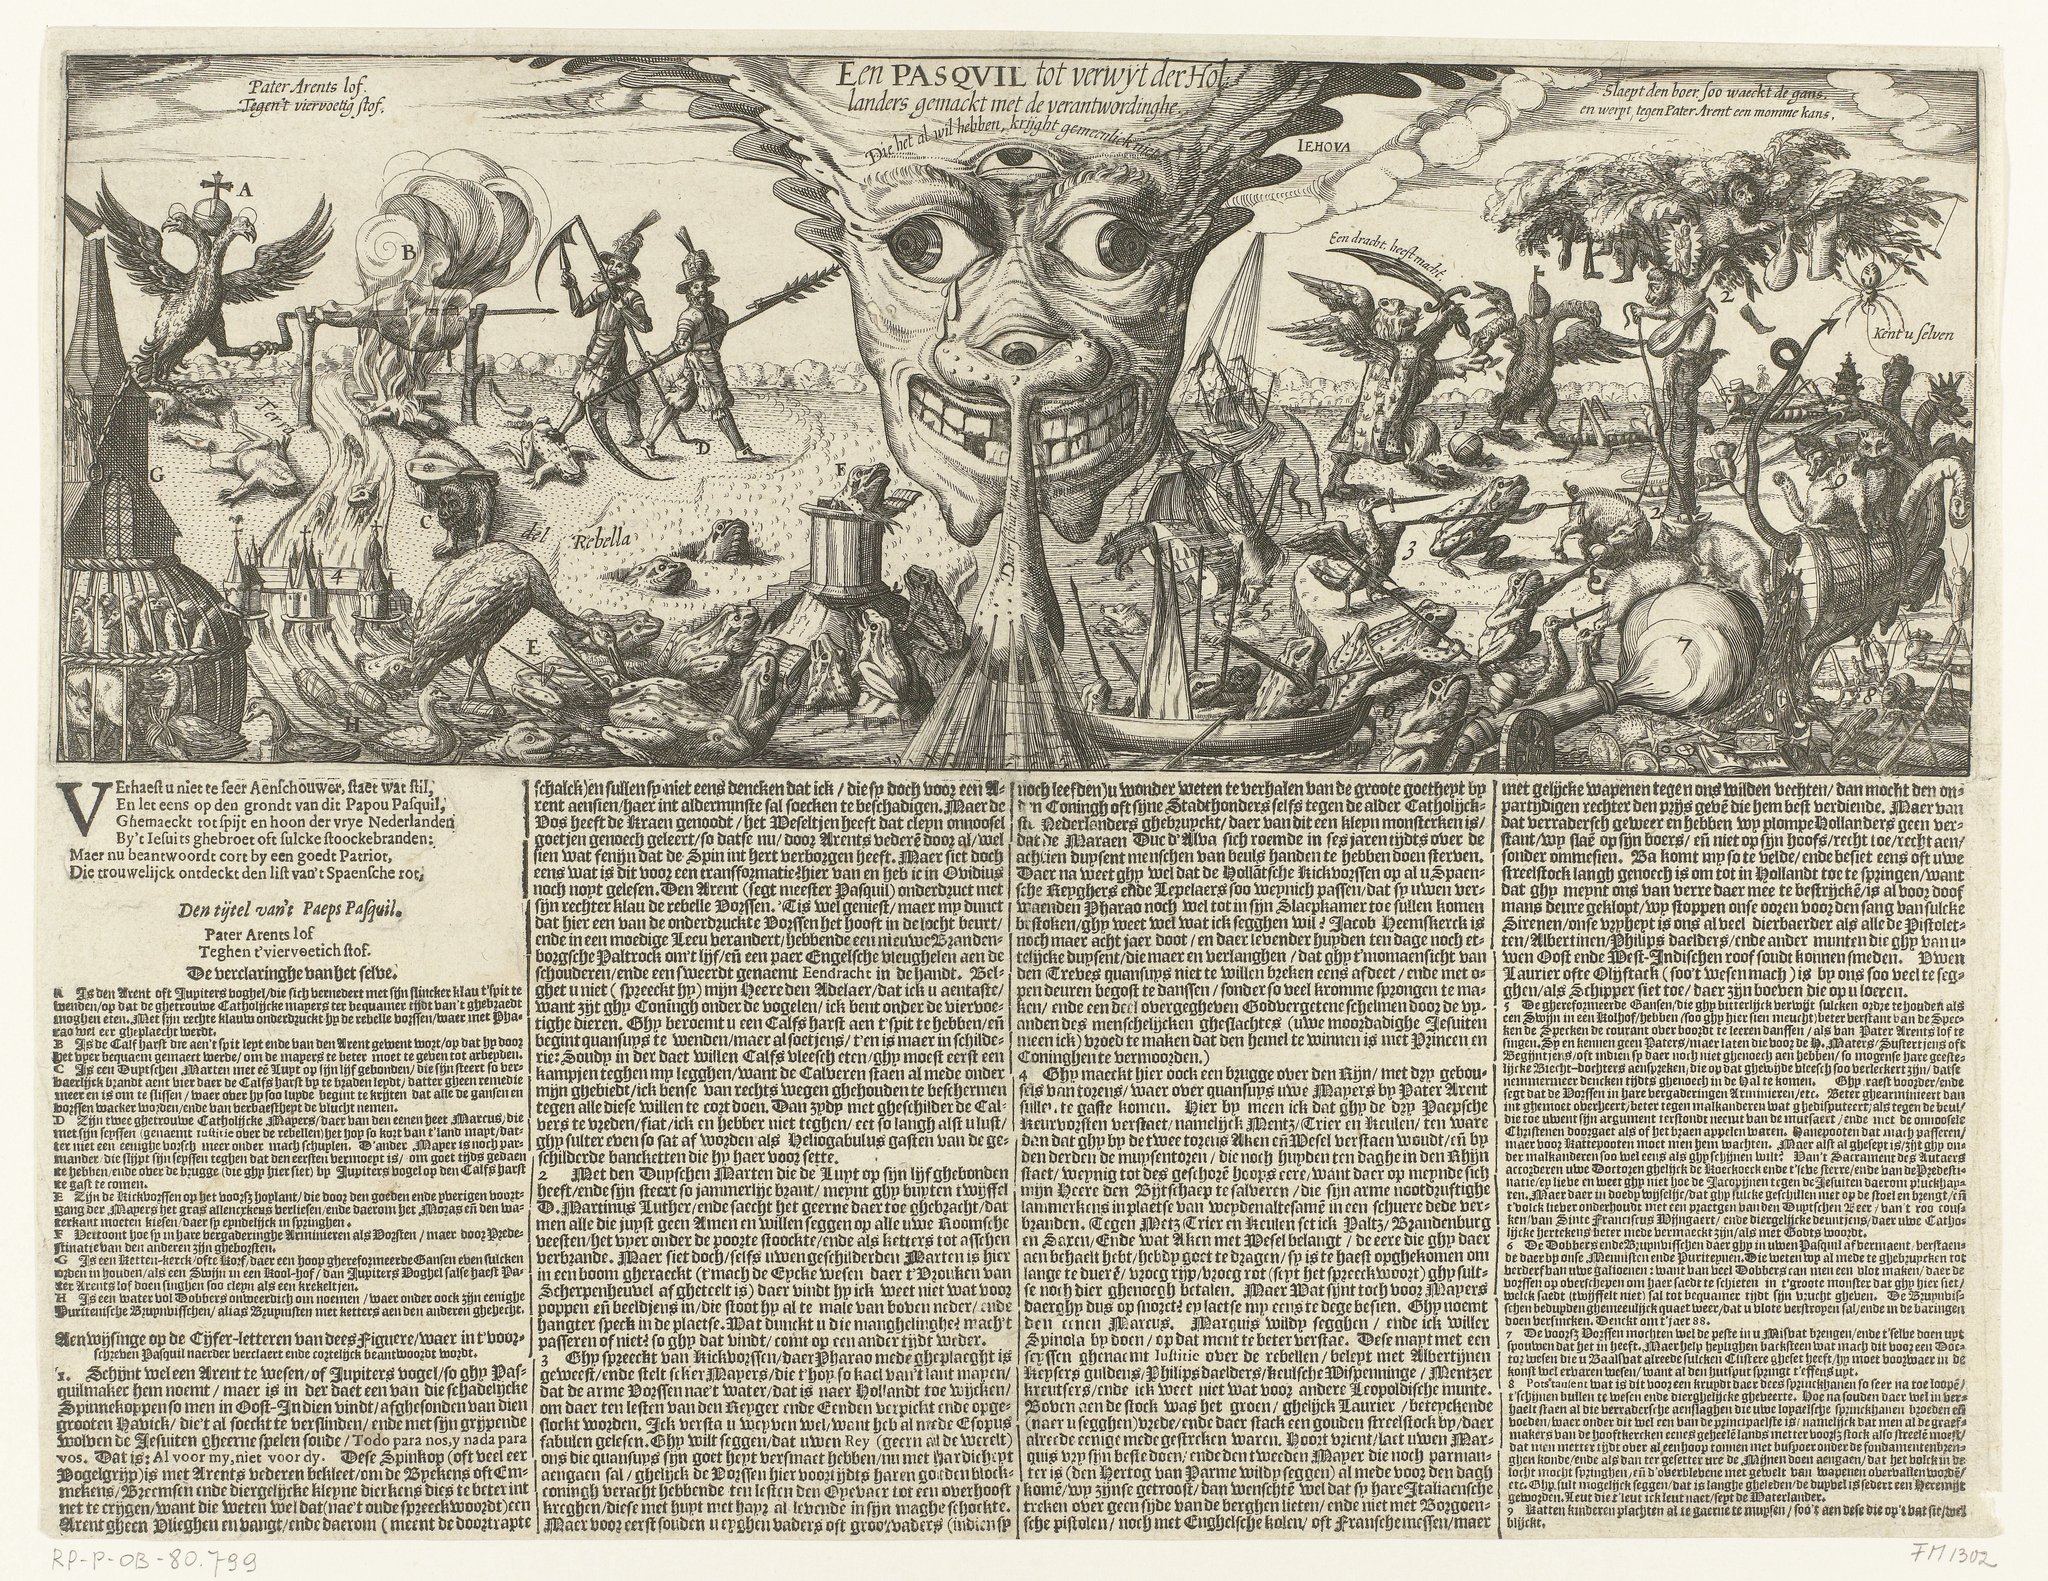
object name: print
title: Een pasquil tot verwijt der Hollanders gemackt met de verantwordinghe: Die het al wil hebben, krijght gemeenlick niet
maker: Anonymous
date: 1615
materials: paper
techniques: etching, letterpress printing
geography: northern netherlands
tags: rome, alessandro farnese (landvoogd van de nederlanden en hertog van parma en piacenza), tailless amphibians: frog, political caricatures and satires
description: Politieke allegorie met links de roomse voorstelling van pater Arents tegen de Hollanders, in het midden een monsterlijke kop, rechts het anti-roomse antwoord waarin de rollen worden omgekeerd. Links braadt de keizerlijke adelaar Gulik aan het spit. Spinola en de hertog van Parma maaien het land van de rebellen waardoor de kikkers (de rebellen) vluchten. Aan de rivieroever een Duitse marter met een luit (Luther). Links een kerk met een kooi van ganzen (geuzen), rechts een kerkdienst van de kikkers. Aan de rechterkant verjagen de kikkers en ganzen de Spaanse varkens en de zevenkoppige Roomse draak. De Hollandse Leeuw houwt een kop van de adelaar af. De Duitse marter heeft de boom beklommen en gooit er de Roomse relikwieën uit. Met onderschrift van 4 kolommen in het Nederlands met de legenda's A-H en 1-9.